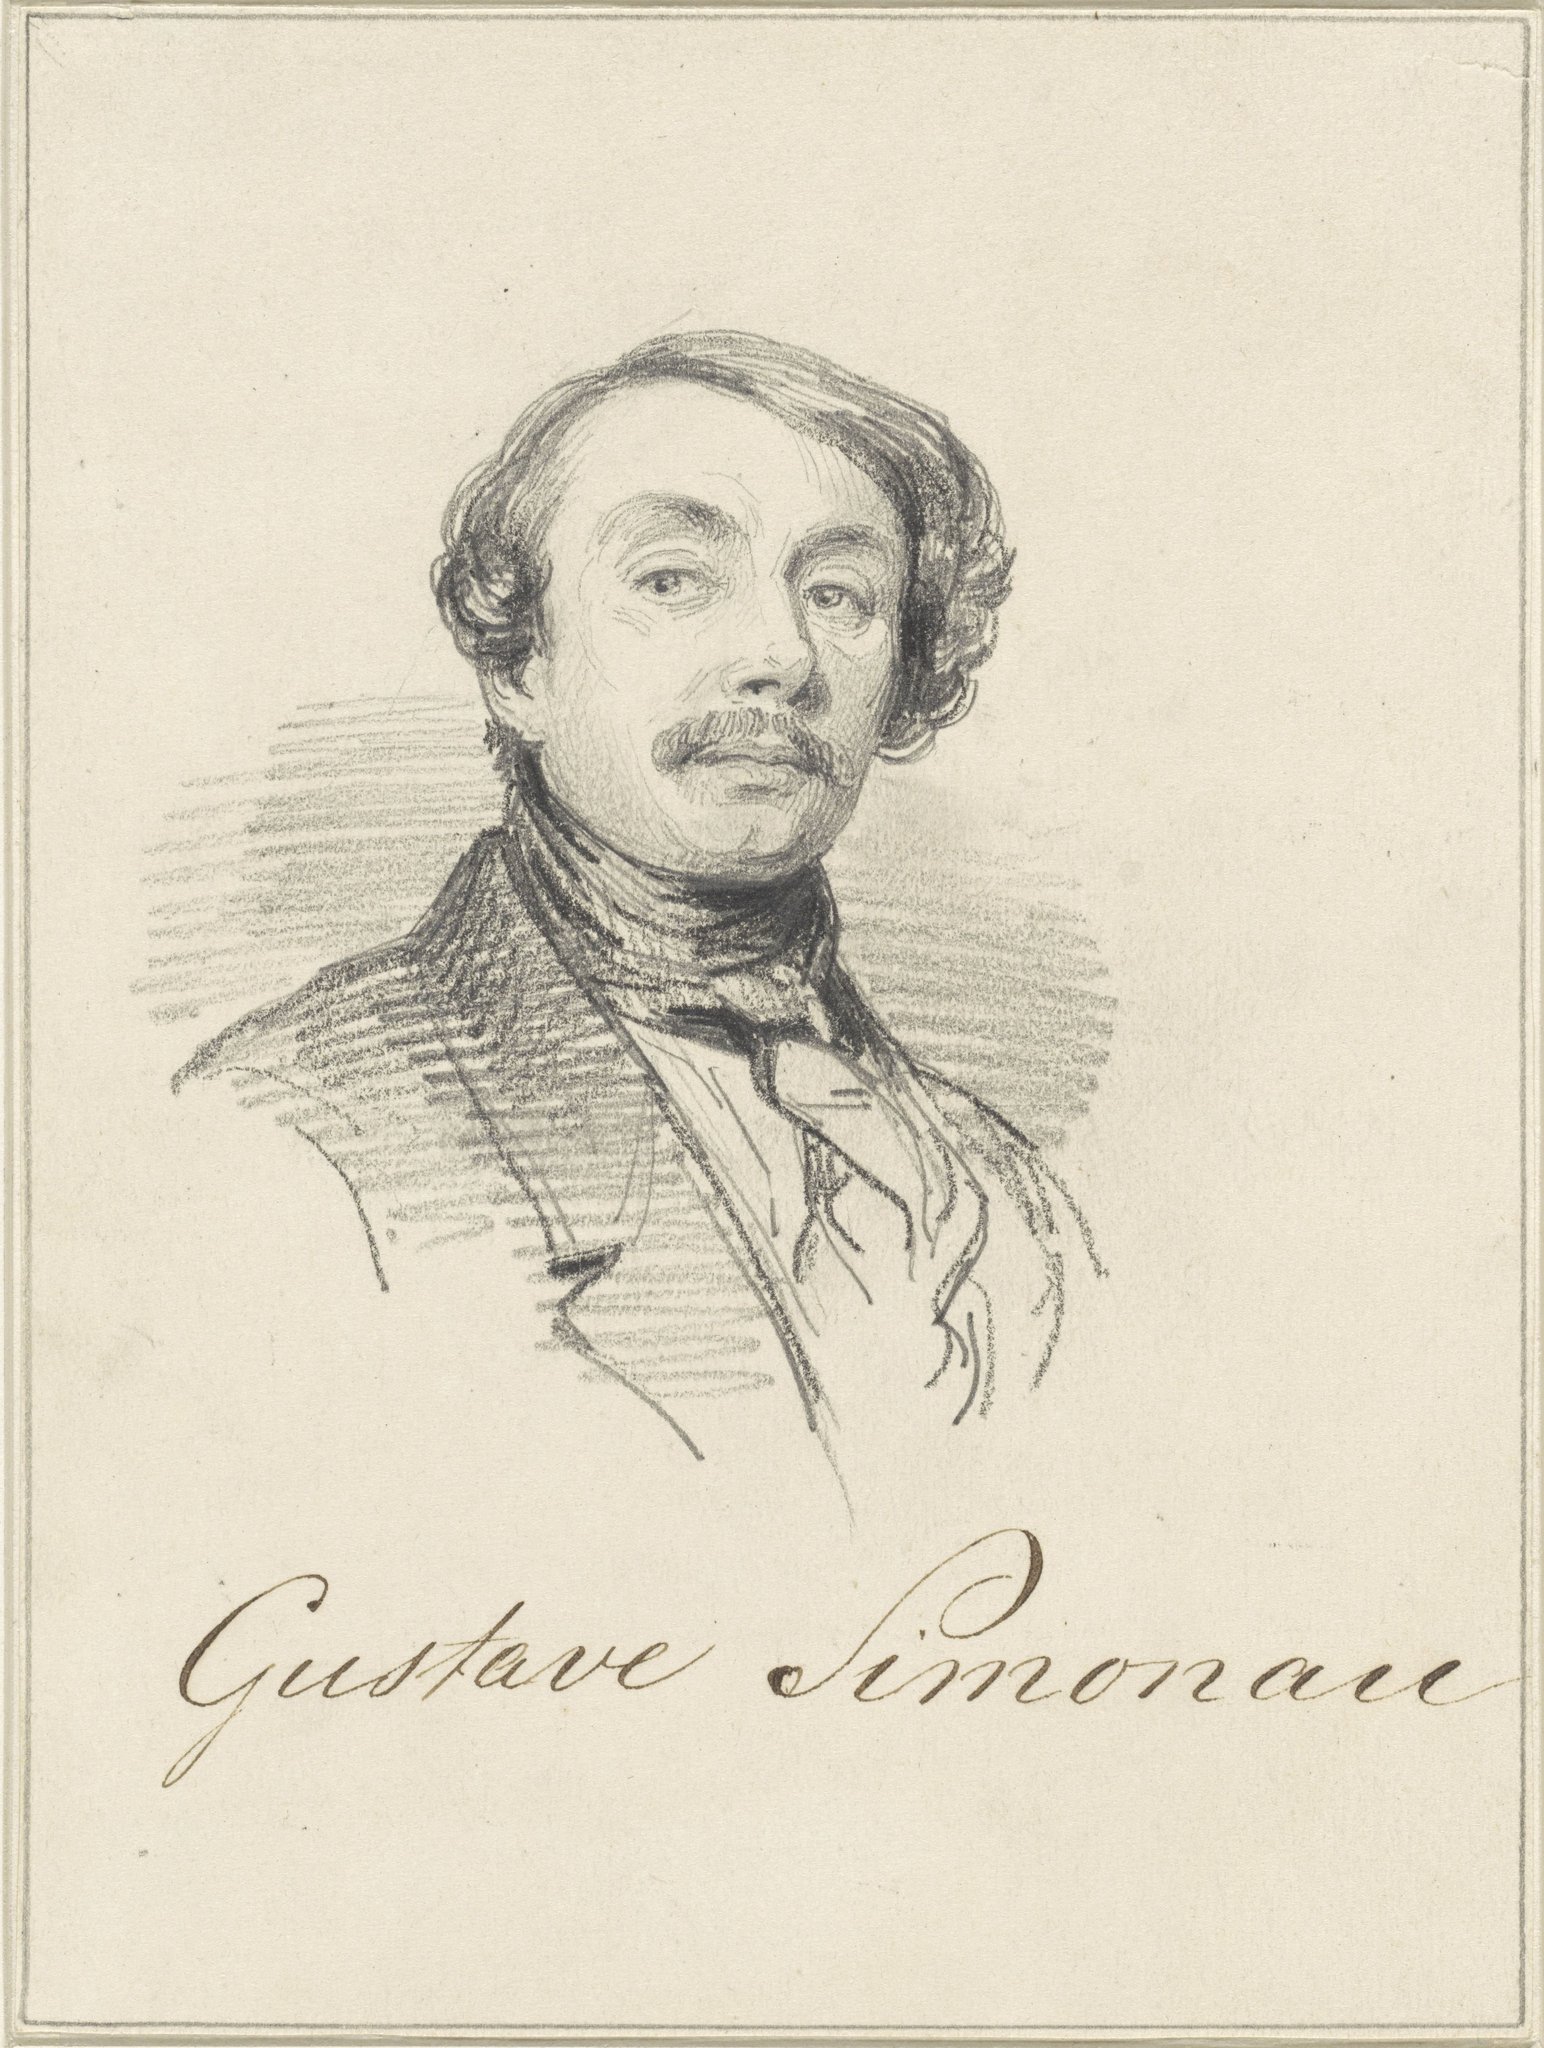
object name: drawing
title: Zelfportret van Gustave Adolphe Simoneau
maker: gustave adolphe simonau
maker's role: draughtsman, print maker, printer, publisher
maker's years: 1810-1870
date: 1820-1870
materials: chalk, paper, pencil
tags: bruges, brussels, print maker, draughtsman, printer, publisher, gustave adolphe simonau, historical persons, portrait, self-portrait of artist